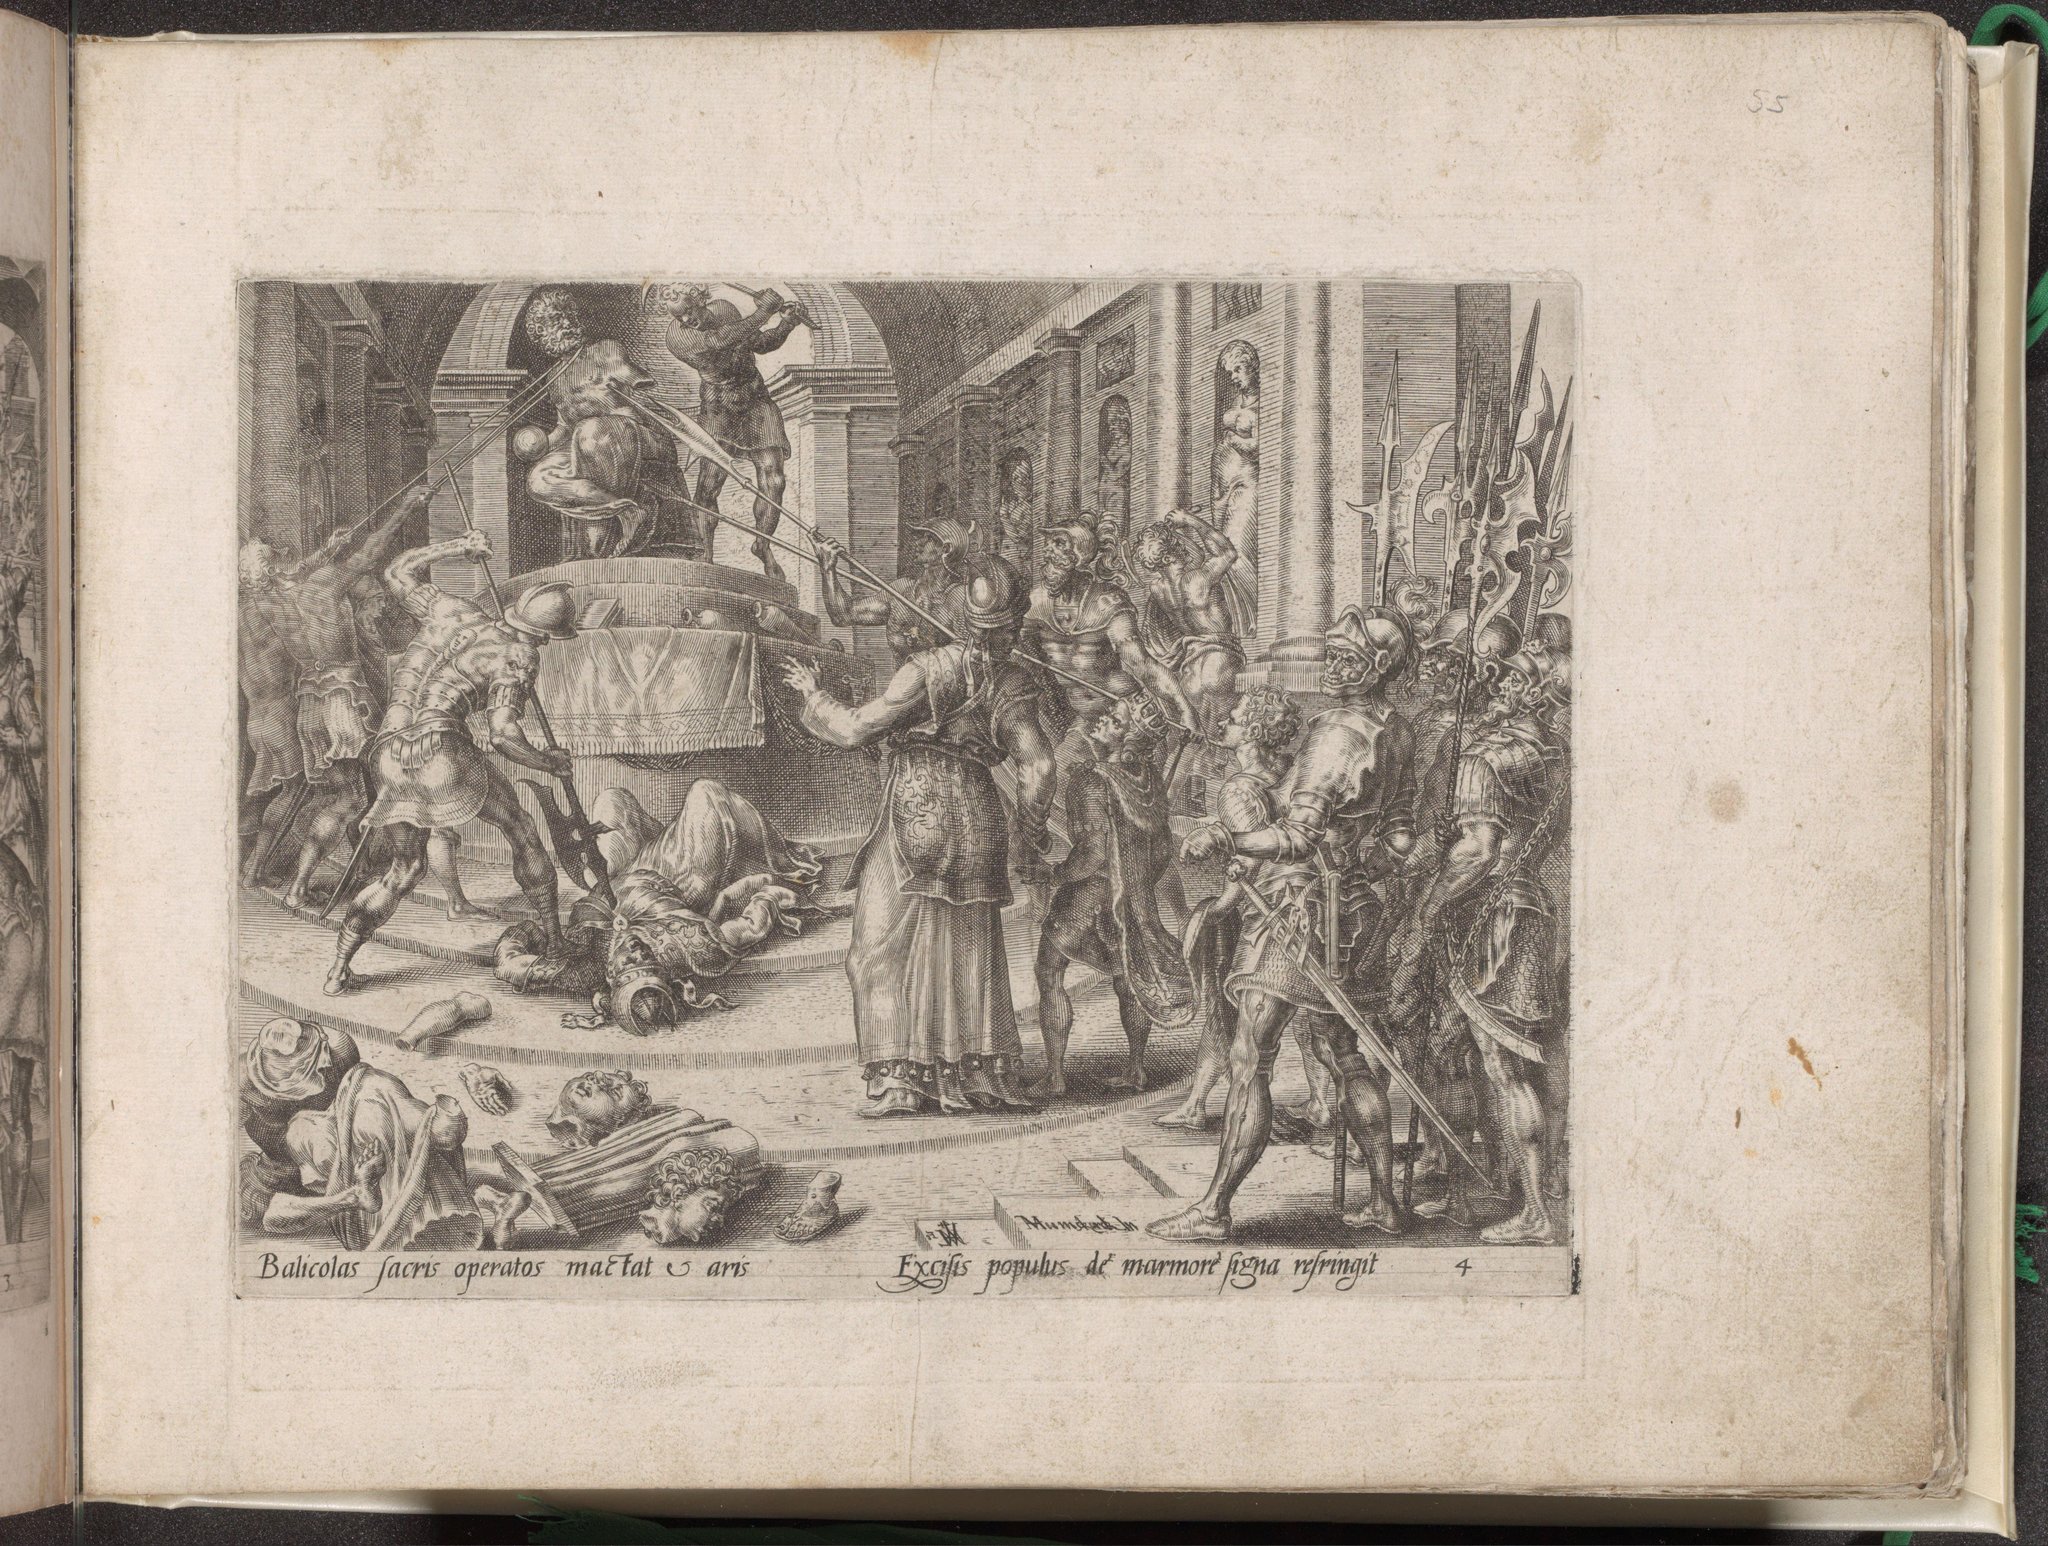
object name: print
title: Verwoesting van de tempel van Baäl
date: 1565-1569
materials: paper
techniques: engraving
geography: antwerp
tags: the people destroy the temple, altars and images of baal, and slay baal's priests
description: In de tempel van Baäl halen mensen de afgodsbeelden omver. Voor het altaar wordt de Baälspriester gedood met een hellebaard. De hogepriester Jojada kijkt met de zevenjarige koning Joas aan de hand toe. Onderaan in de marge een vers in het Latijn over de voorstelling. Deze prent maakt deel uit van een album.